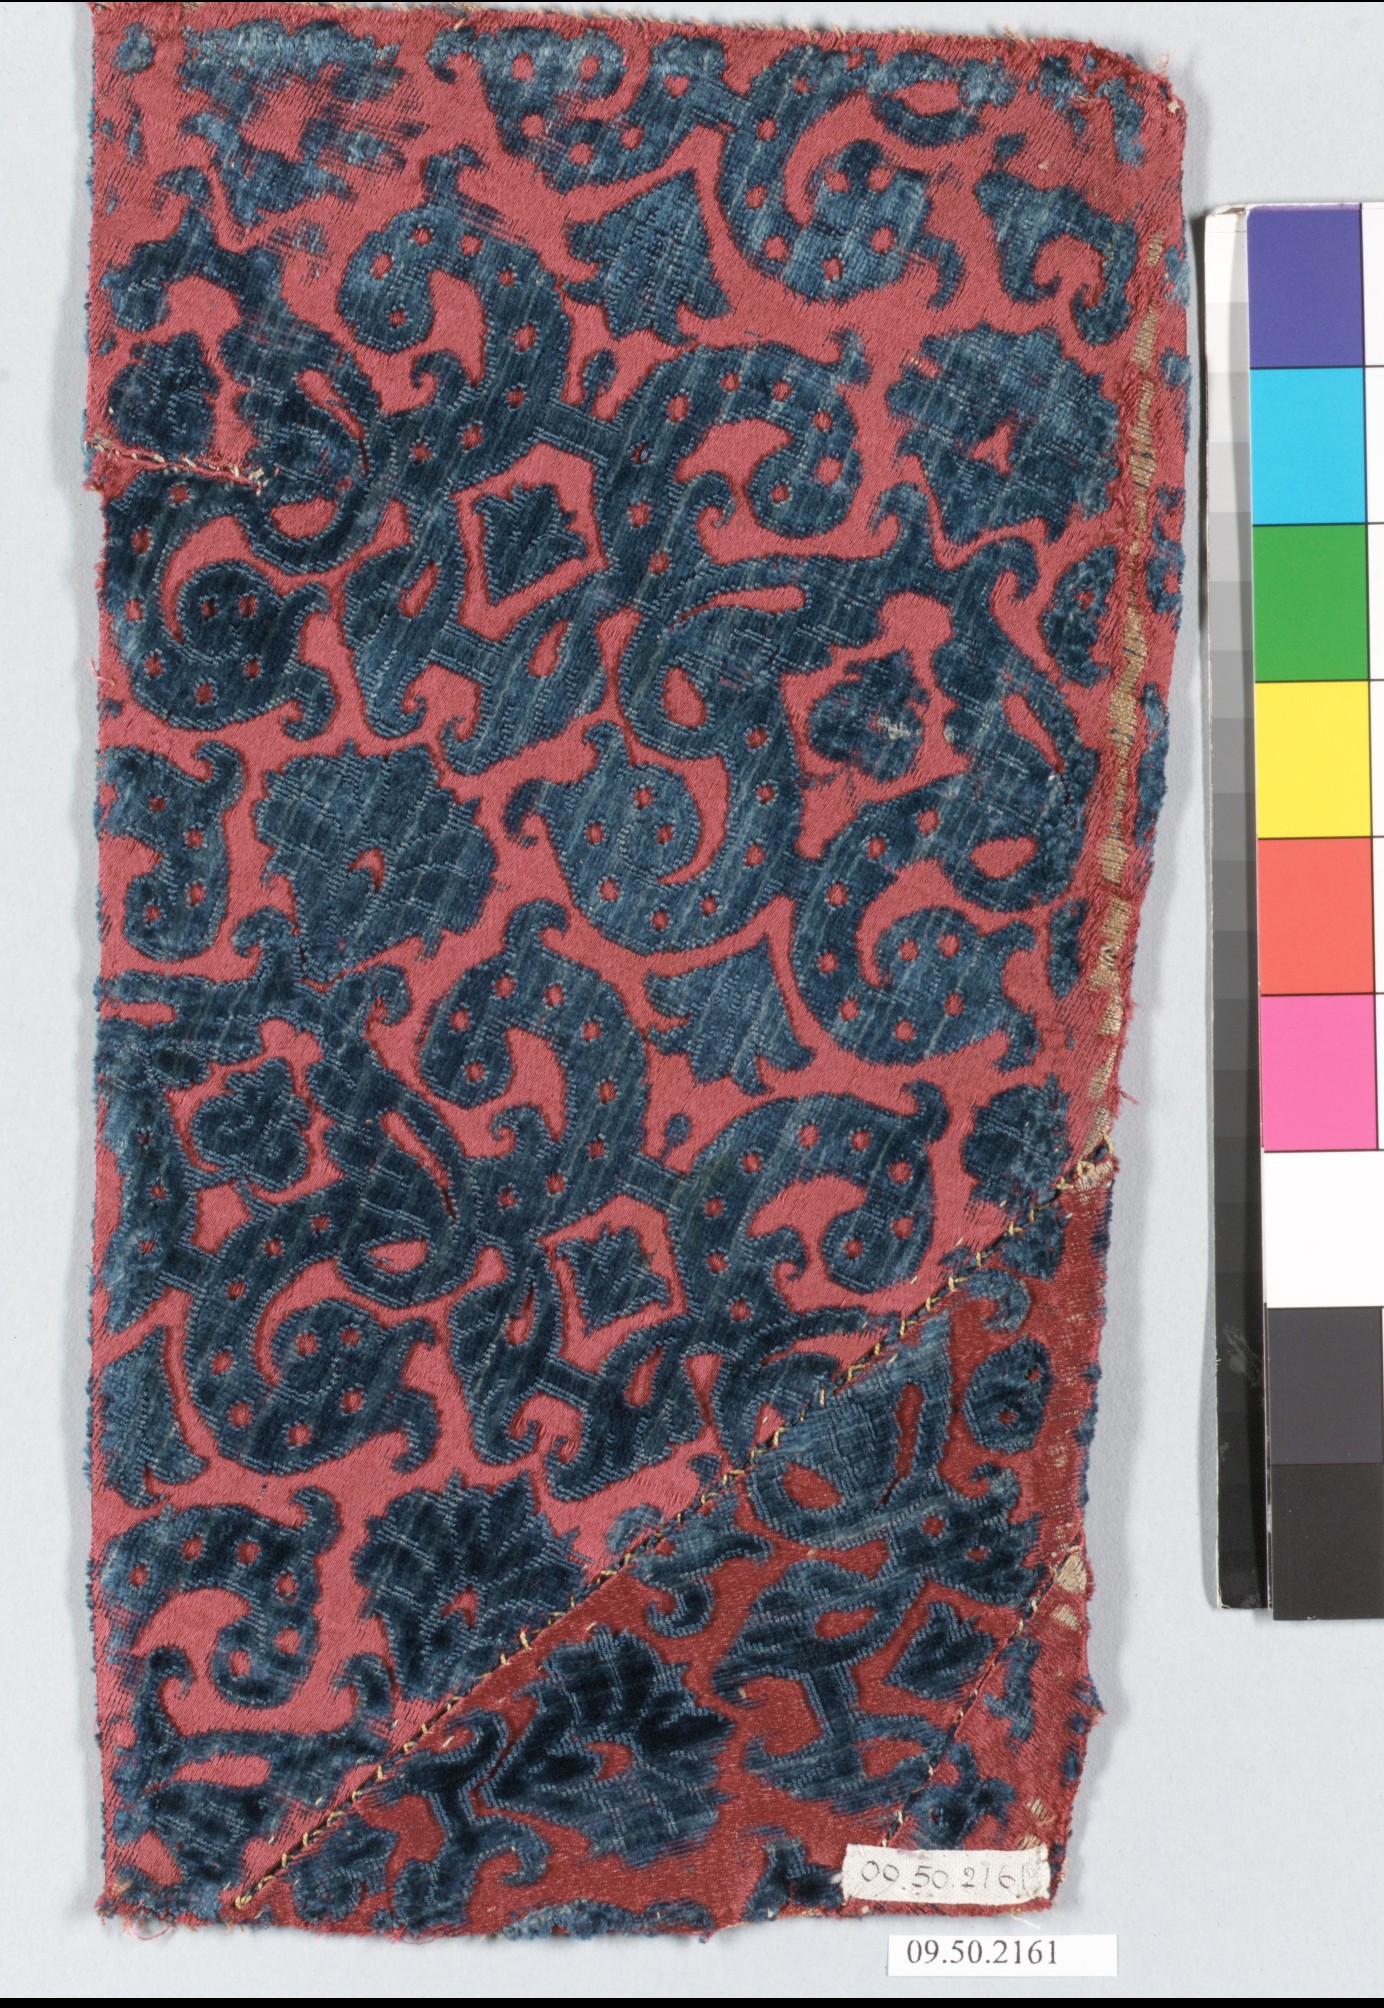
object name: piece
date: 1501-1700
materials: silk